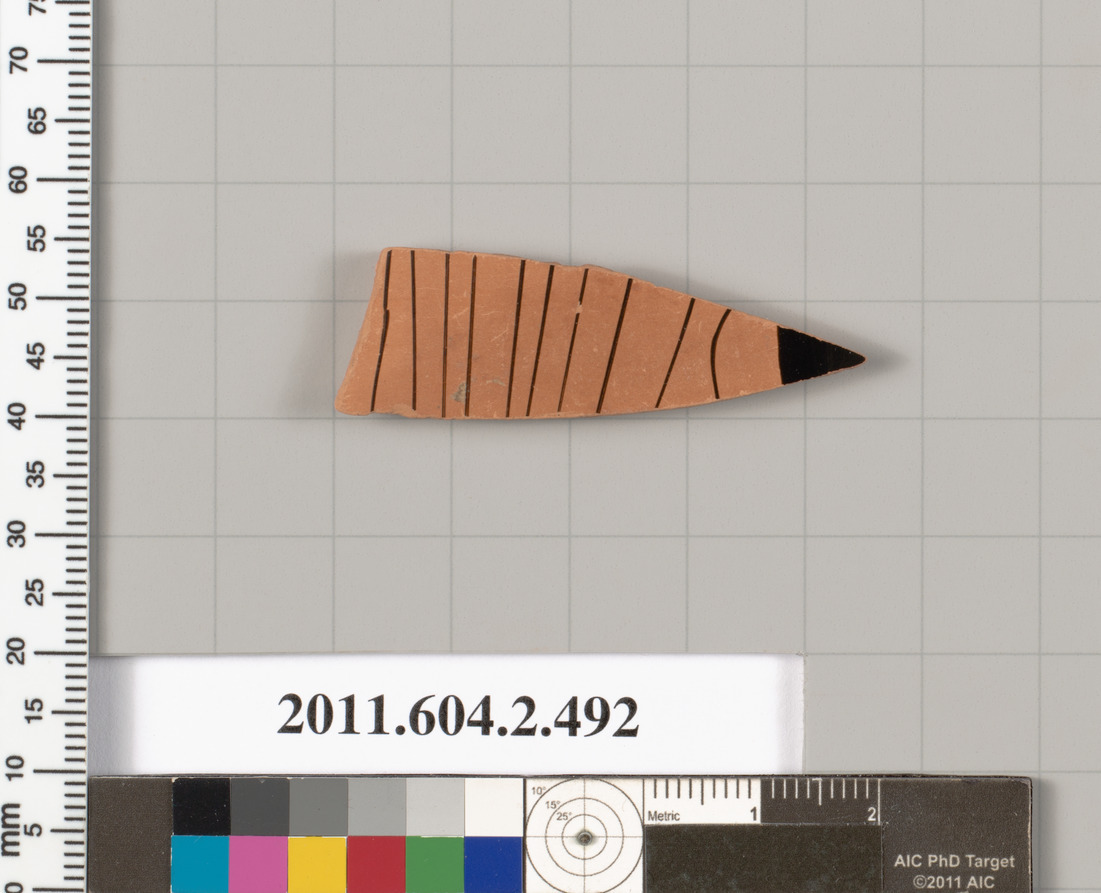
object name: column krater fragment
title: Terracotta fragment of a column-krater (bowl for mixing wine and water)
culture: greek, attic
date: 460-440 BCE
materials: terracotta